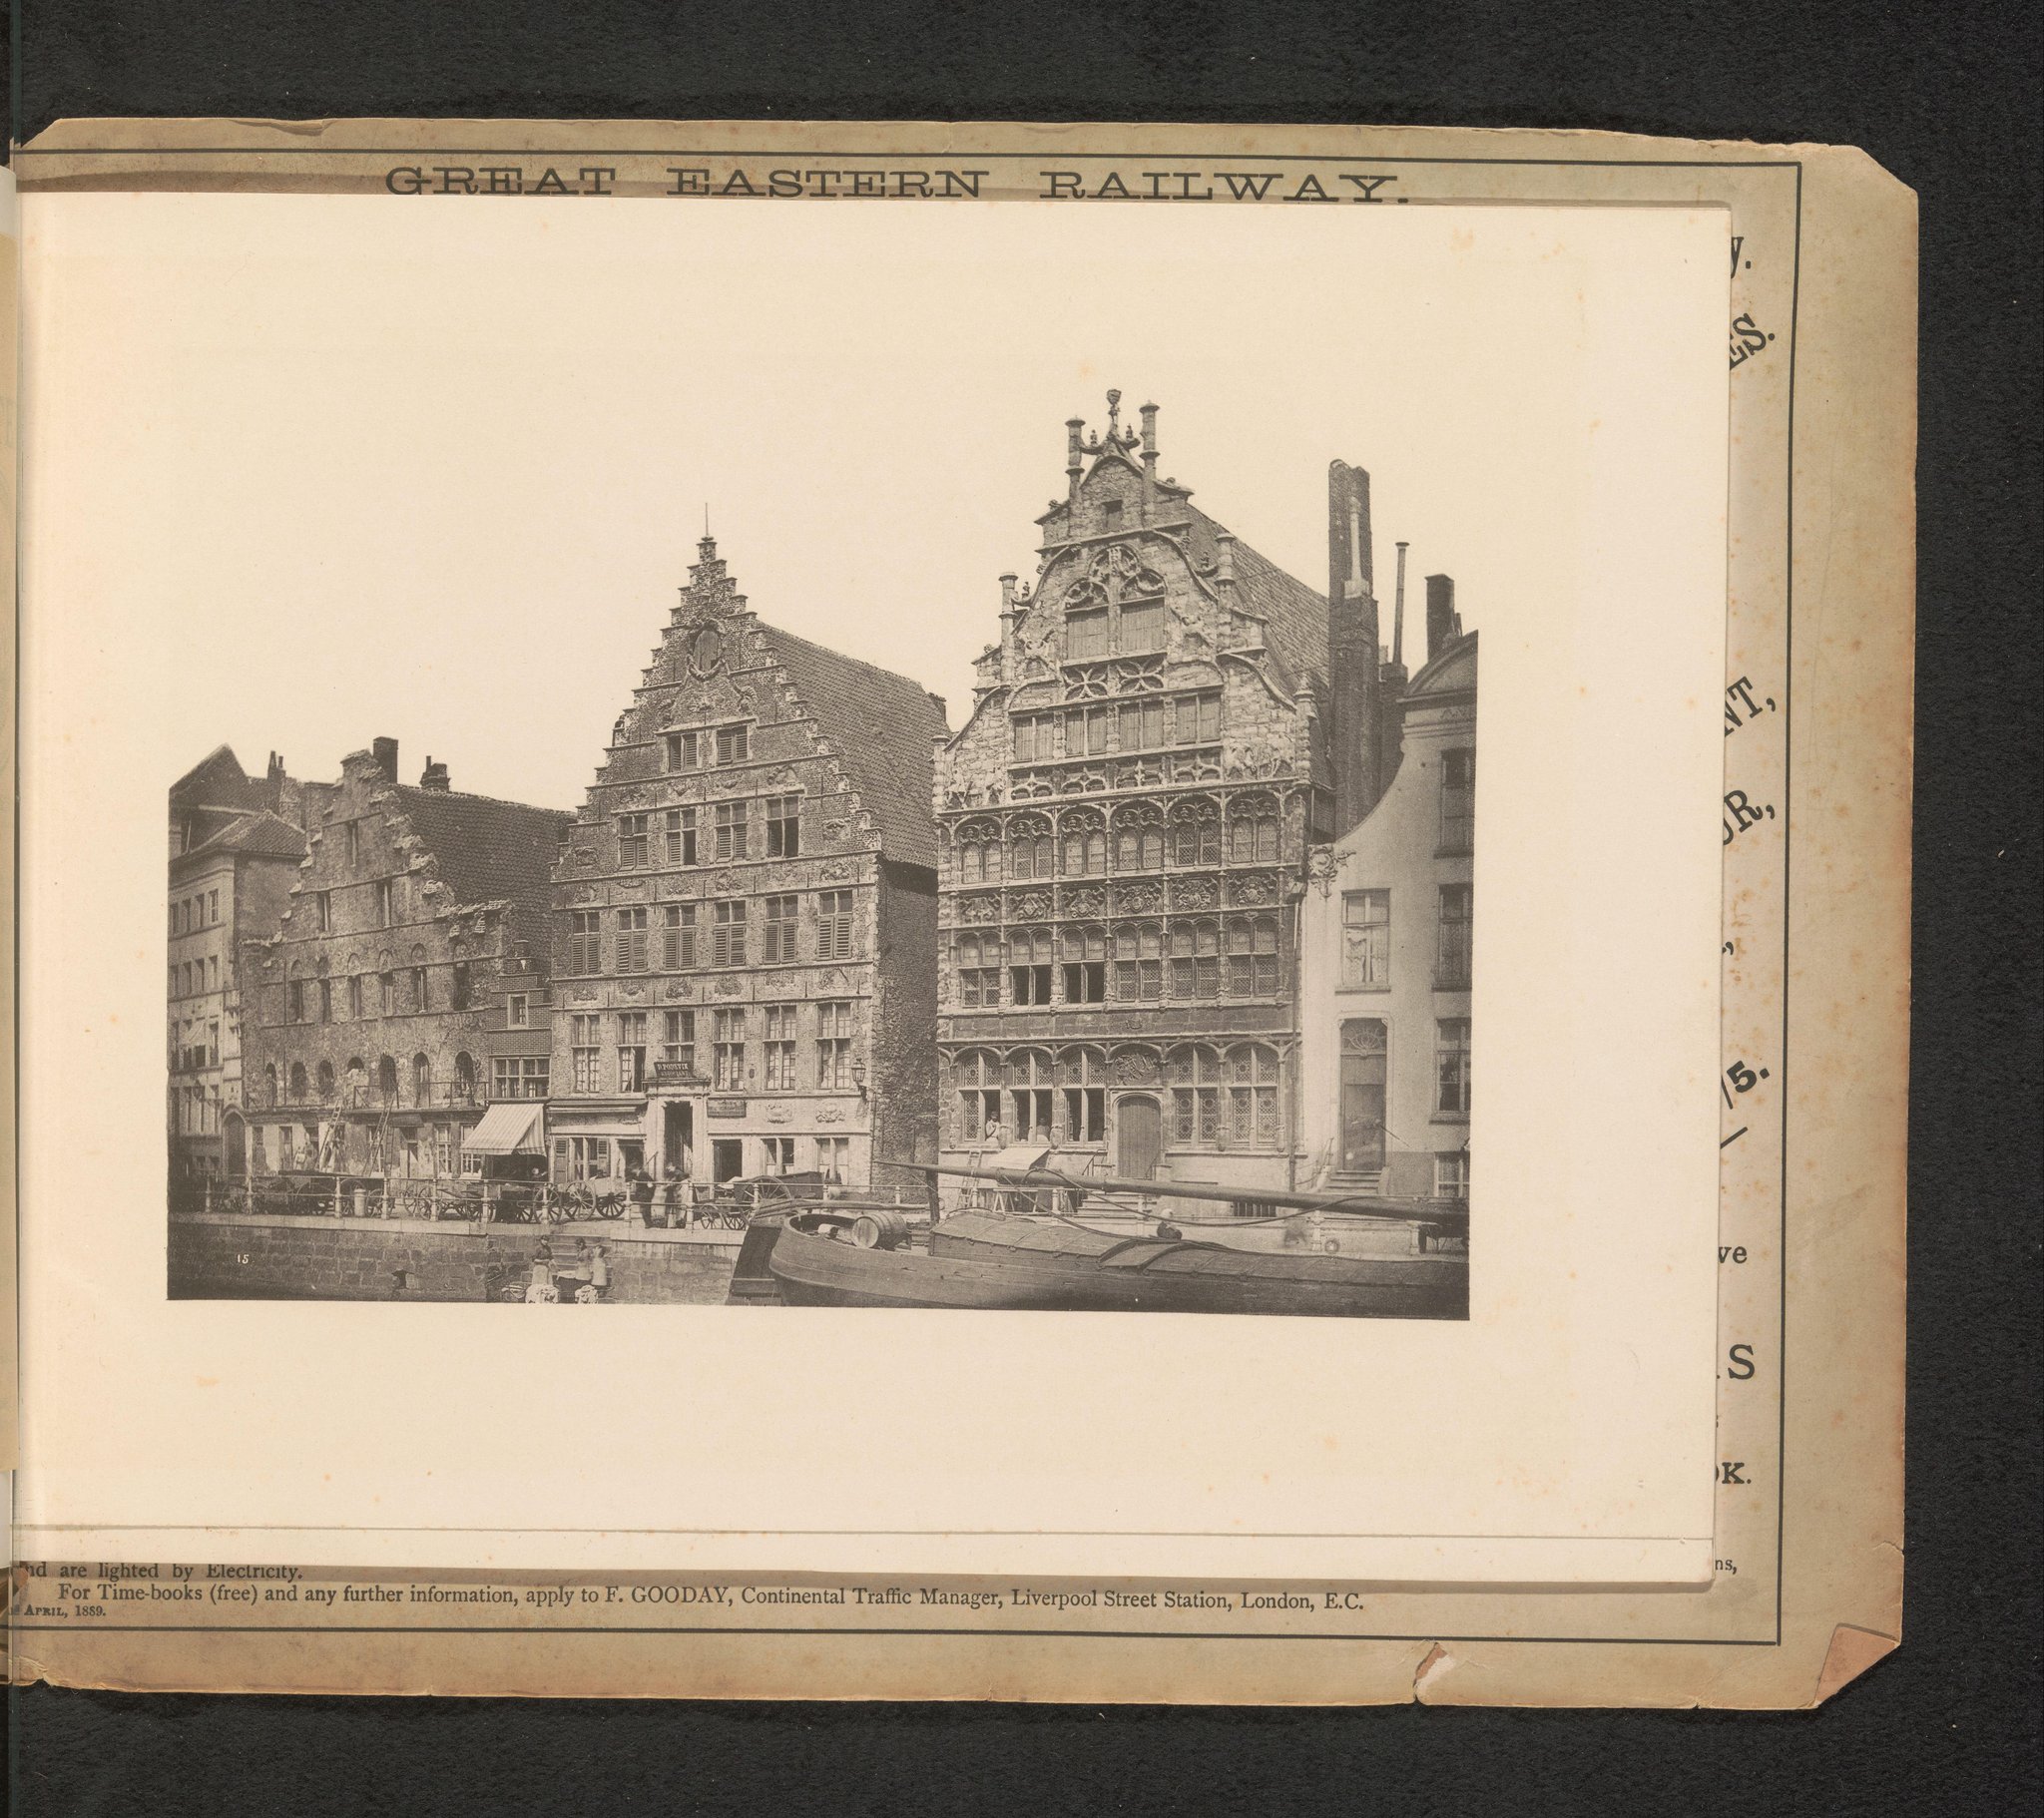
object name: page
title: Drie huizen aan de Graslei in Gent, België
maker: Anonymous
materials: paper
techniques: photograph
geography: ghent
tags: canals, waters (in city), the usual house or row of houses, ghent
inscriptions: number: ‘15’